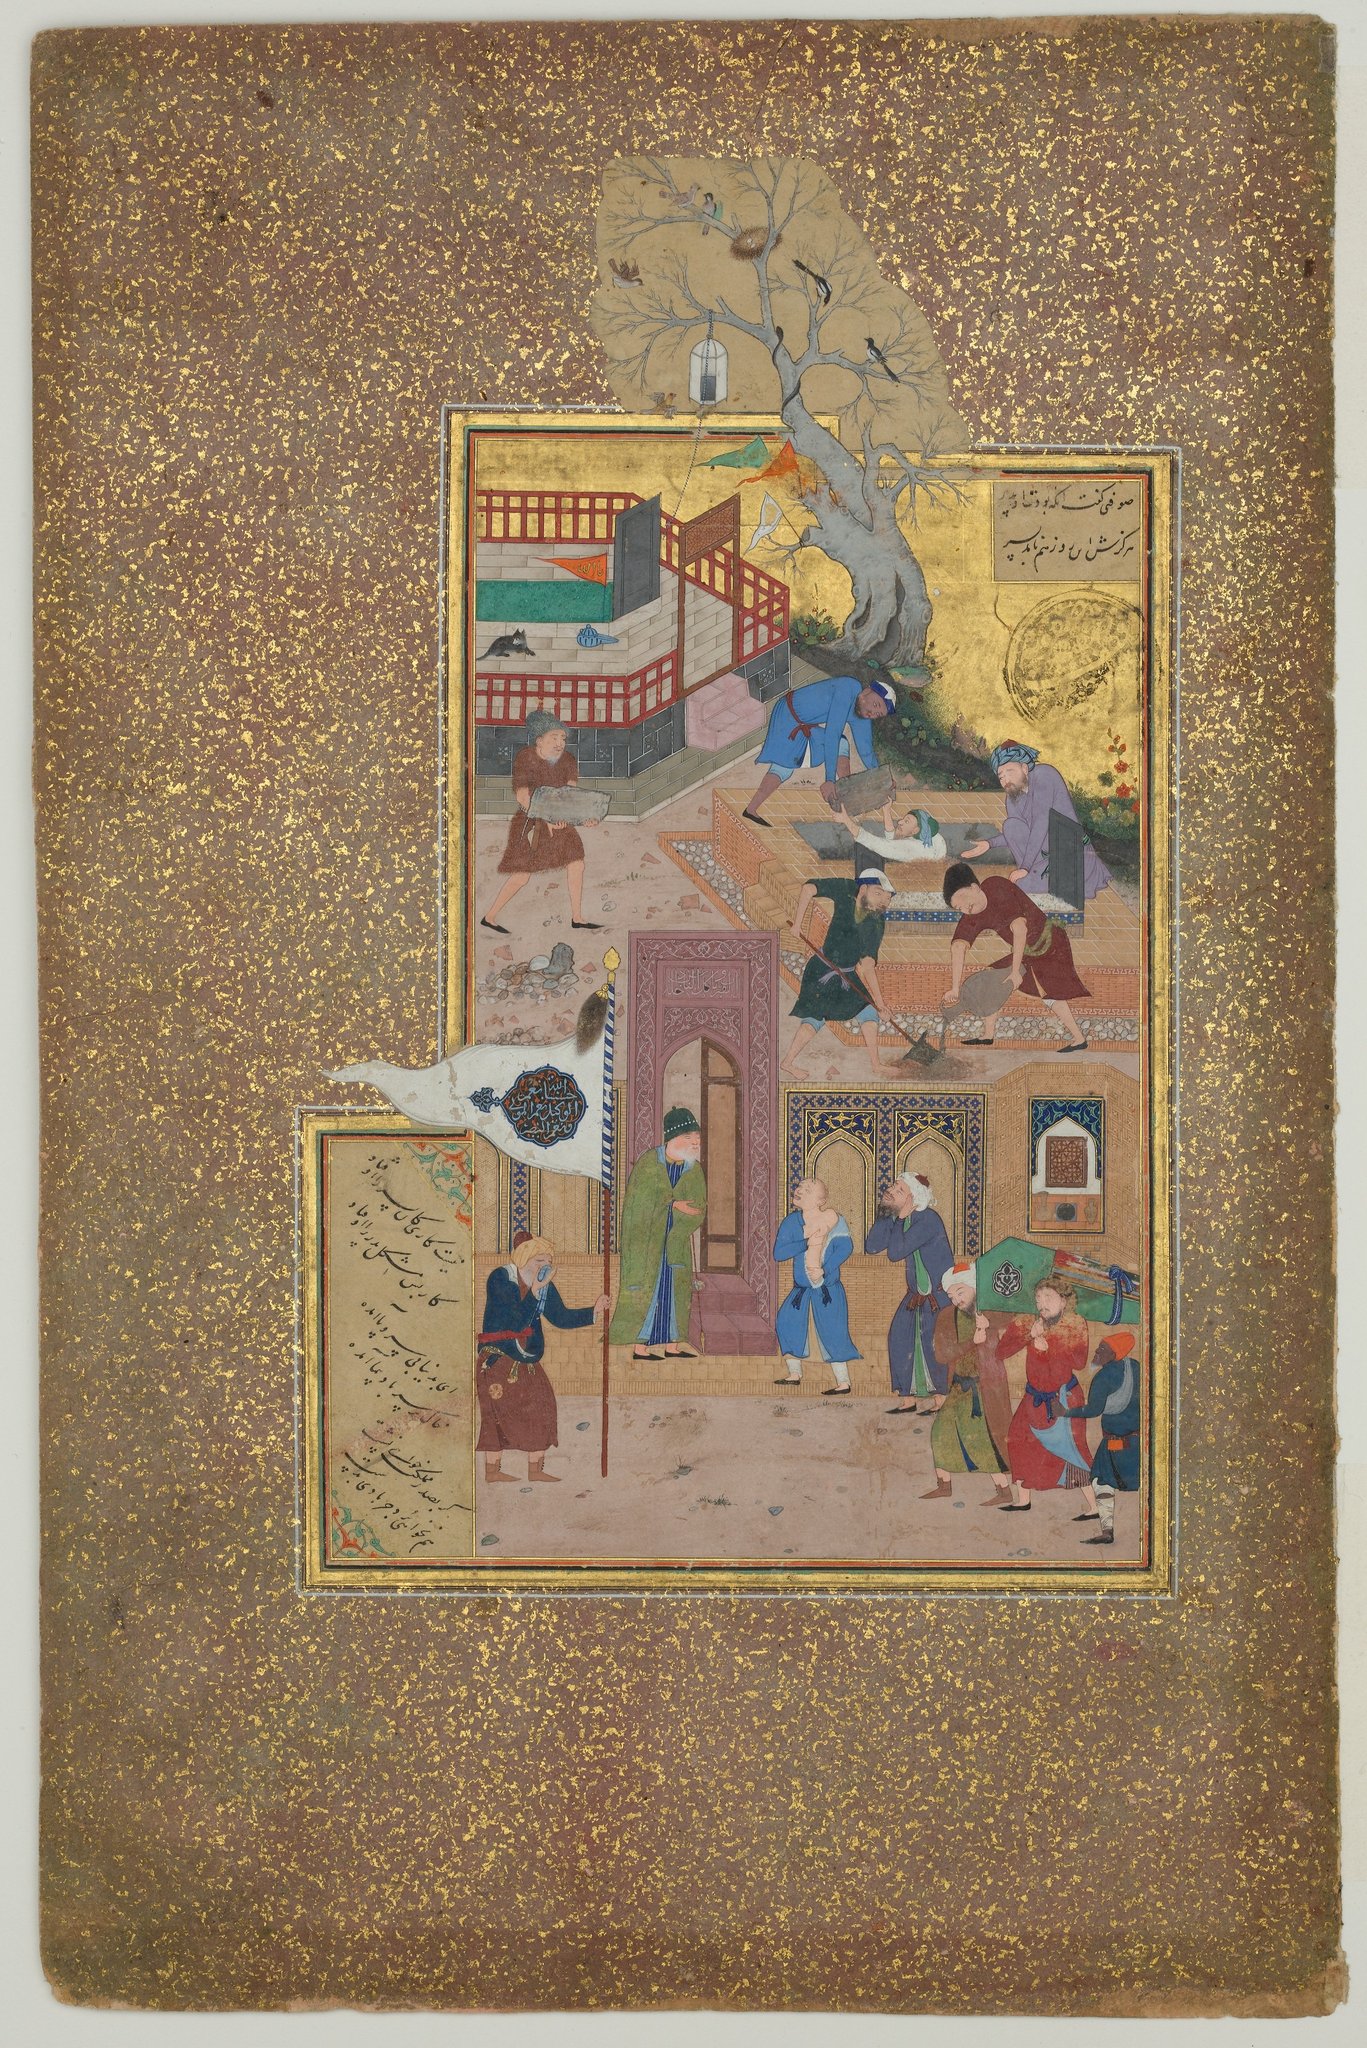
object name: folio from an illustrated manuscript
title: "Funeral Procession", Folio 35r from a Mantiq al-Tayr (Language of the Birds)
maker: sultan 'ali al-mashhadi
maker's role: calligrapher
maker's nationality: iranian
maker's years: 1453-1520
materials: gold, paper, silver, watercolor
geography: afghanistan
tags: men,funerals,working